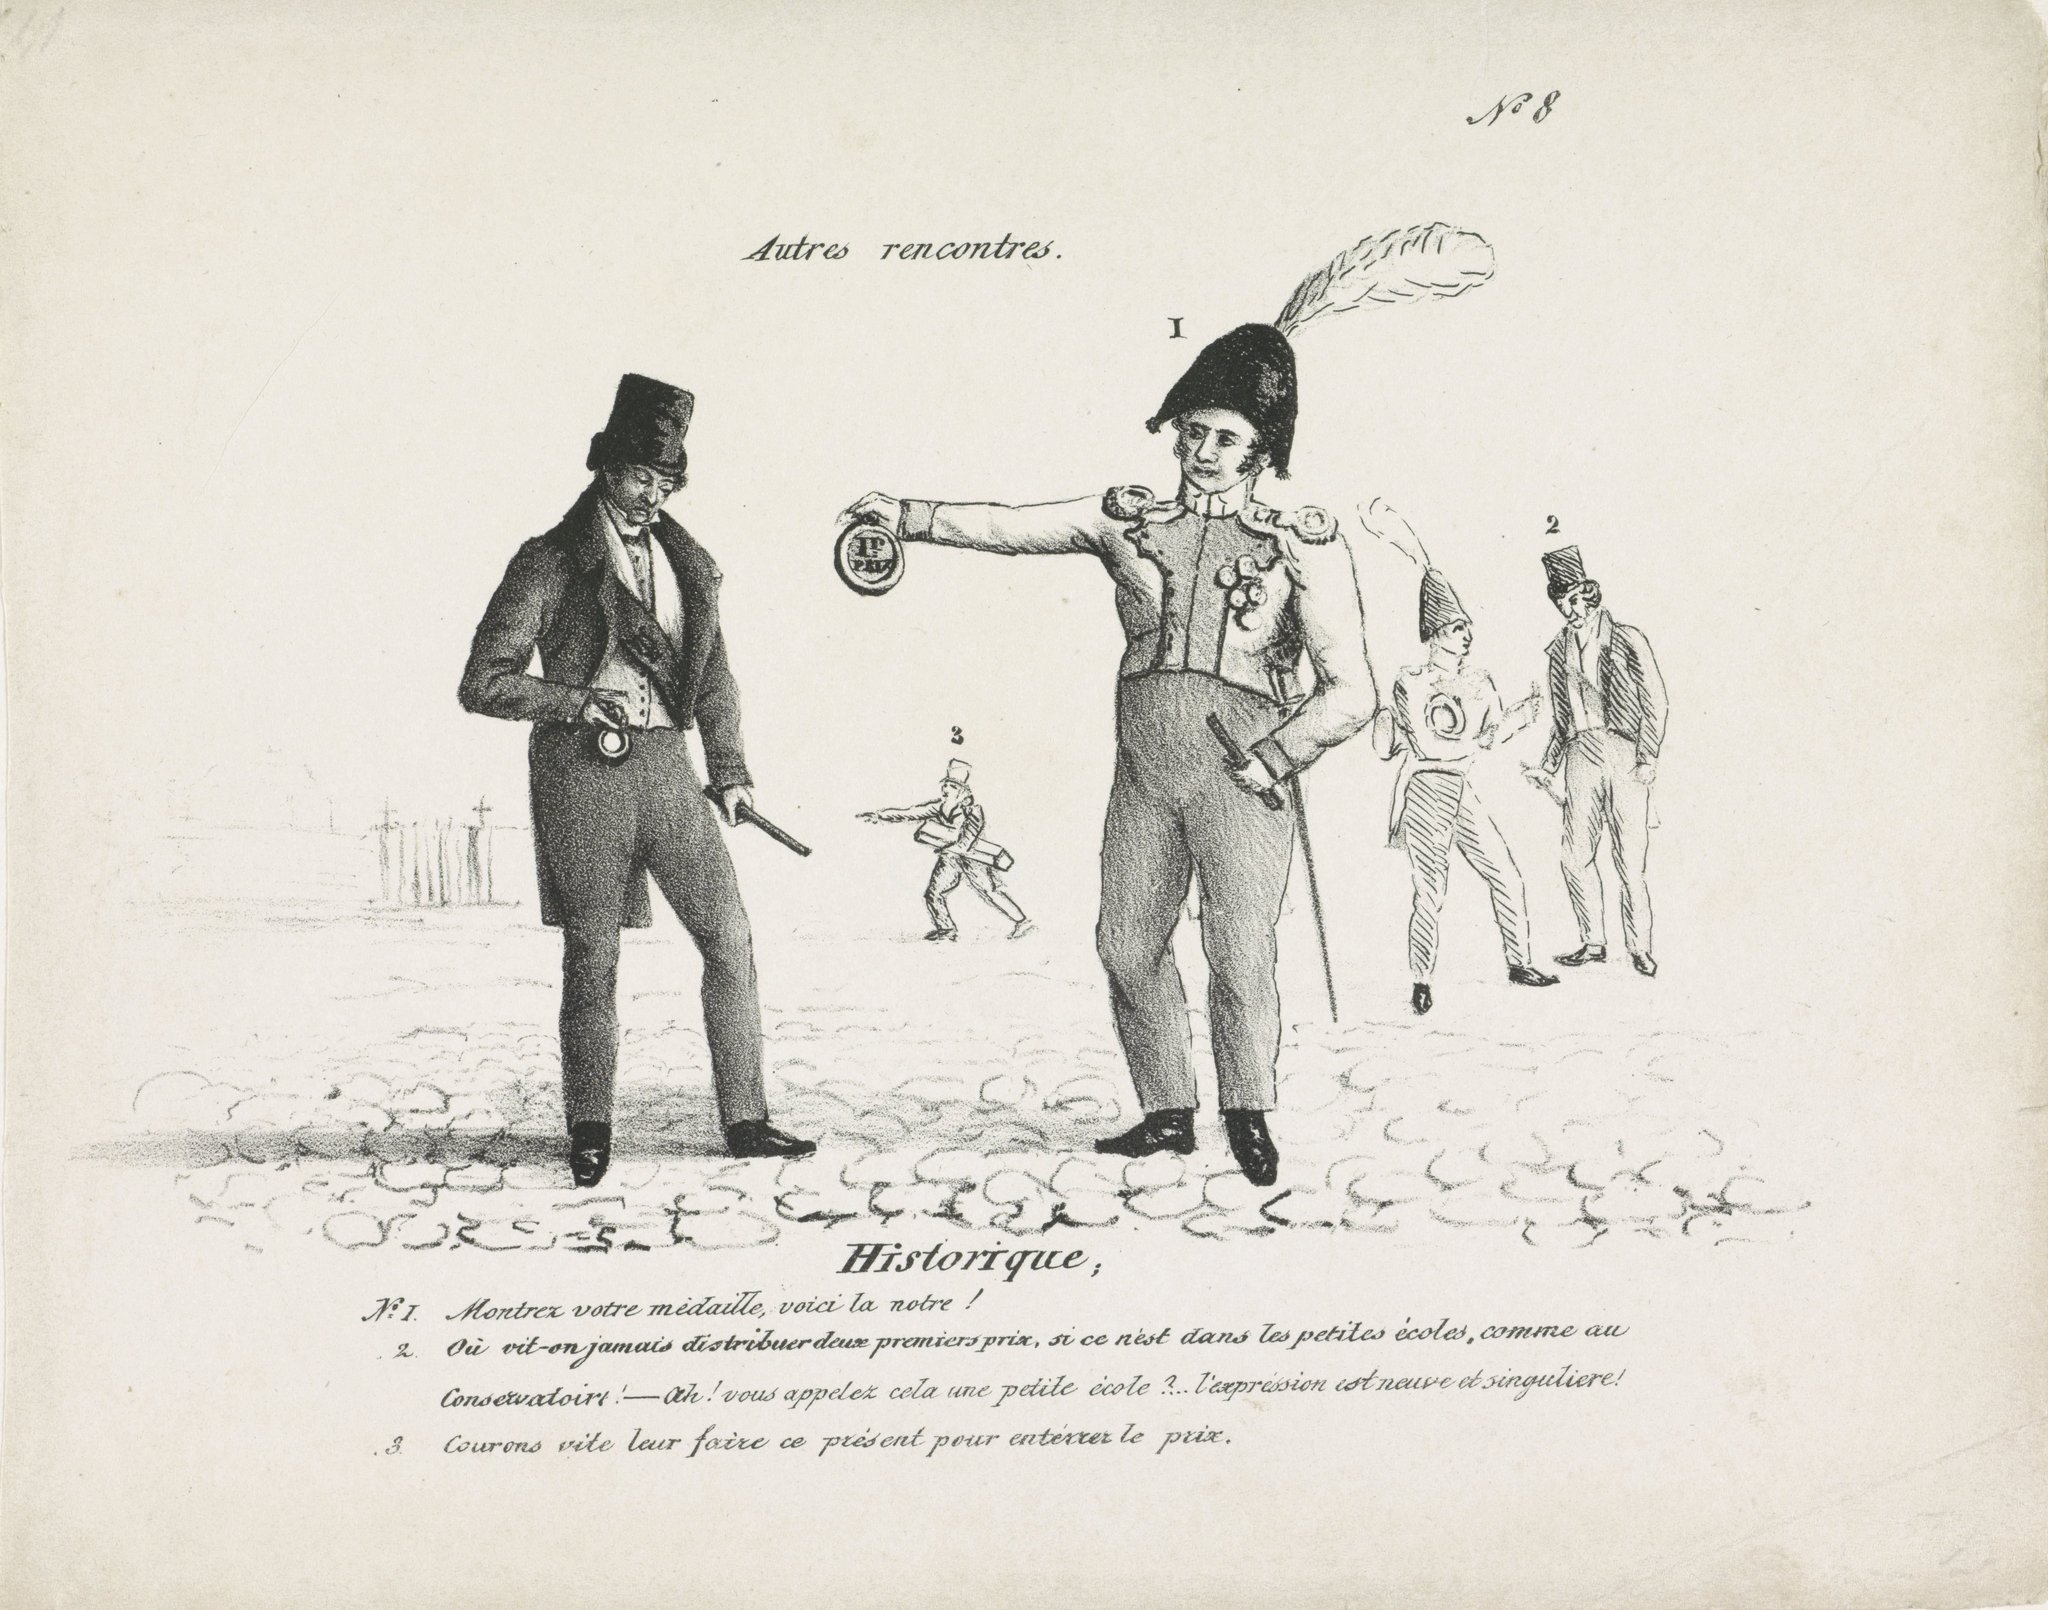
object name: print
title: Historique No. 8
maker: Anonymous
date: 1829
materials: paper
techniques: lithograph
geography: southern netherlands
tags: distribution of awards ~ art contest, competition, art contest, ghent, brussels, lille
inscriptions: collector's mark: Lugt 2228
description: Spotprent op het muziekconcours gehouden te Lille op 30 juni 1829. De Gentse kapelmeester d'Hollander (in uniform) toont De Munck van Brussel zijn eerste prijs, een medaille met inscriptie. De Munck van Brussel bekijkt ook zijn medaille voor de eerste prijs, deze medaille is echter blanco, zonder inscriptie. Met legenda 1-3. Er ontstond onenigheid of de Vereeniging St. Caecilia uit Gent of de Harmonie van Brussel de eerste prijs op de muziek concours gehouden te Lille had gewonnen.